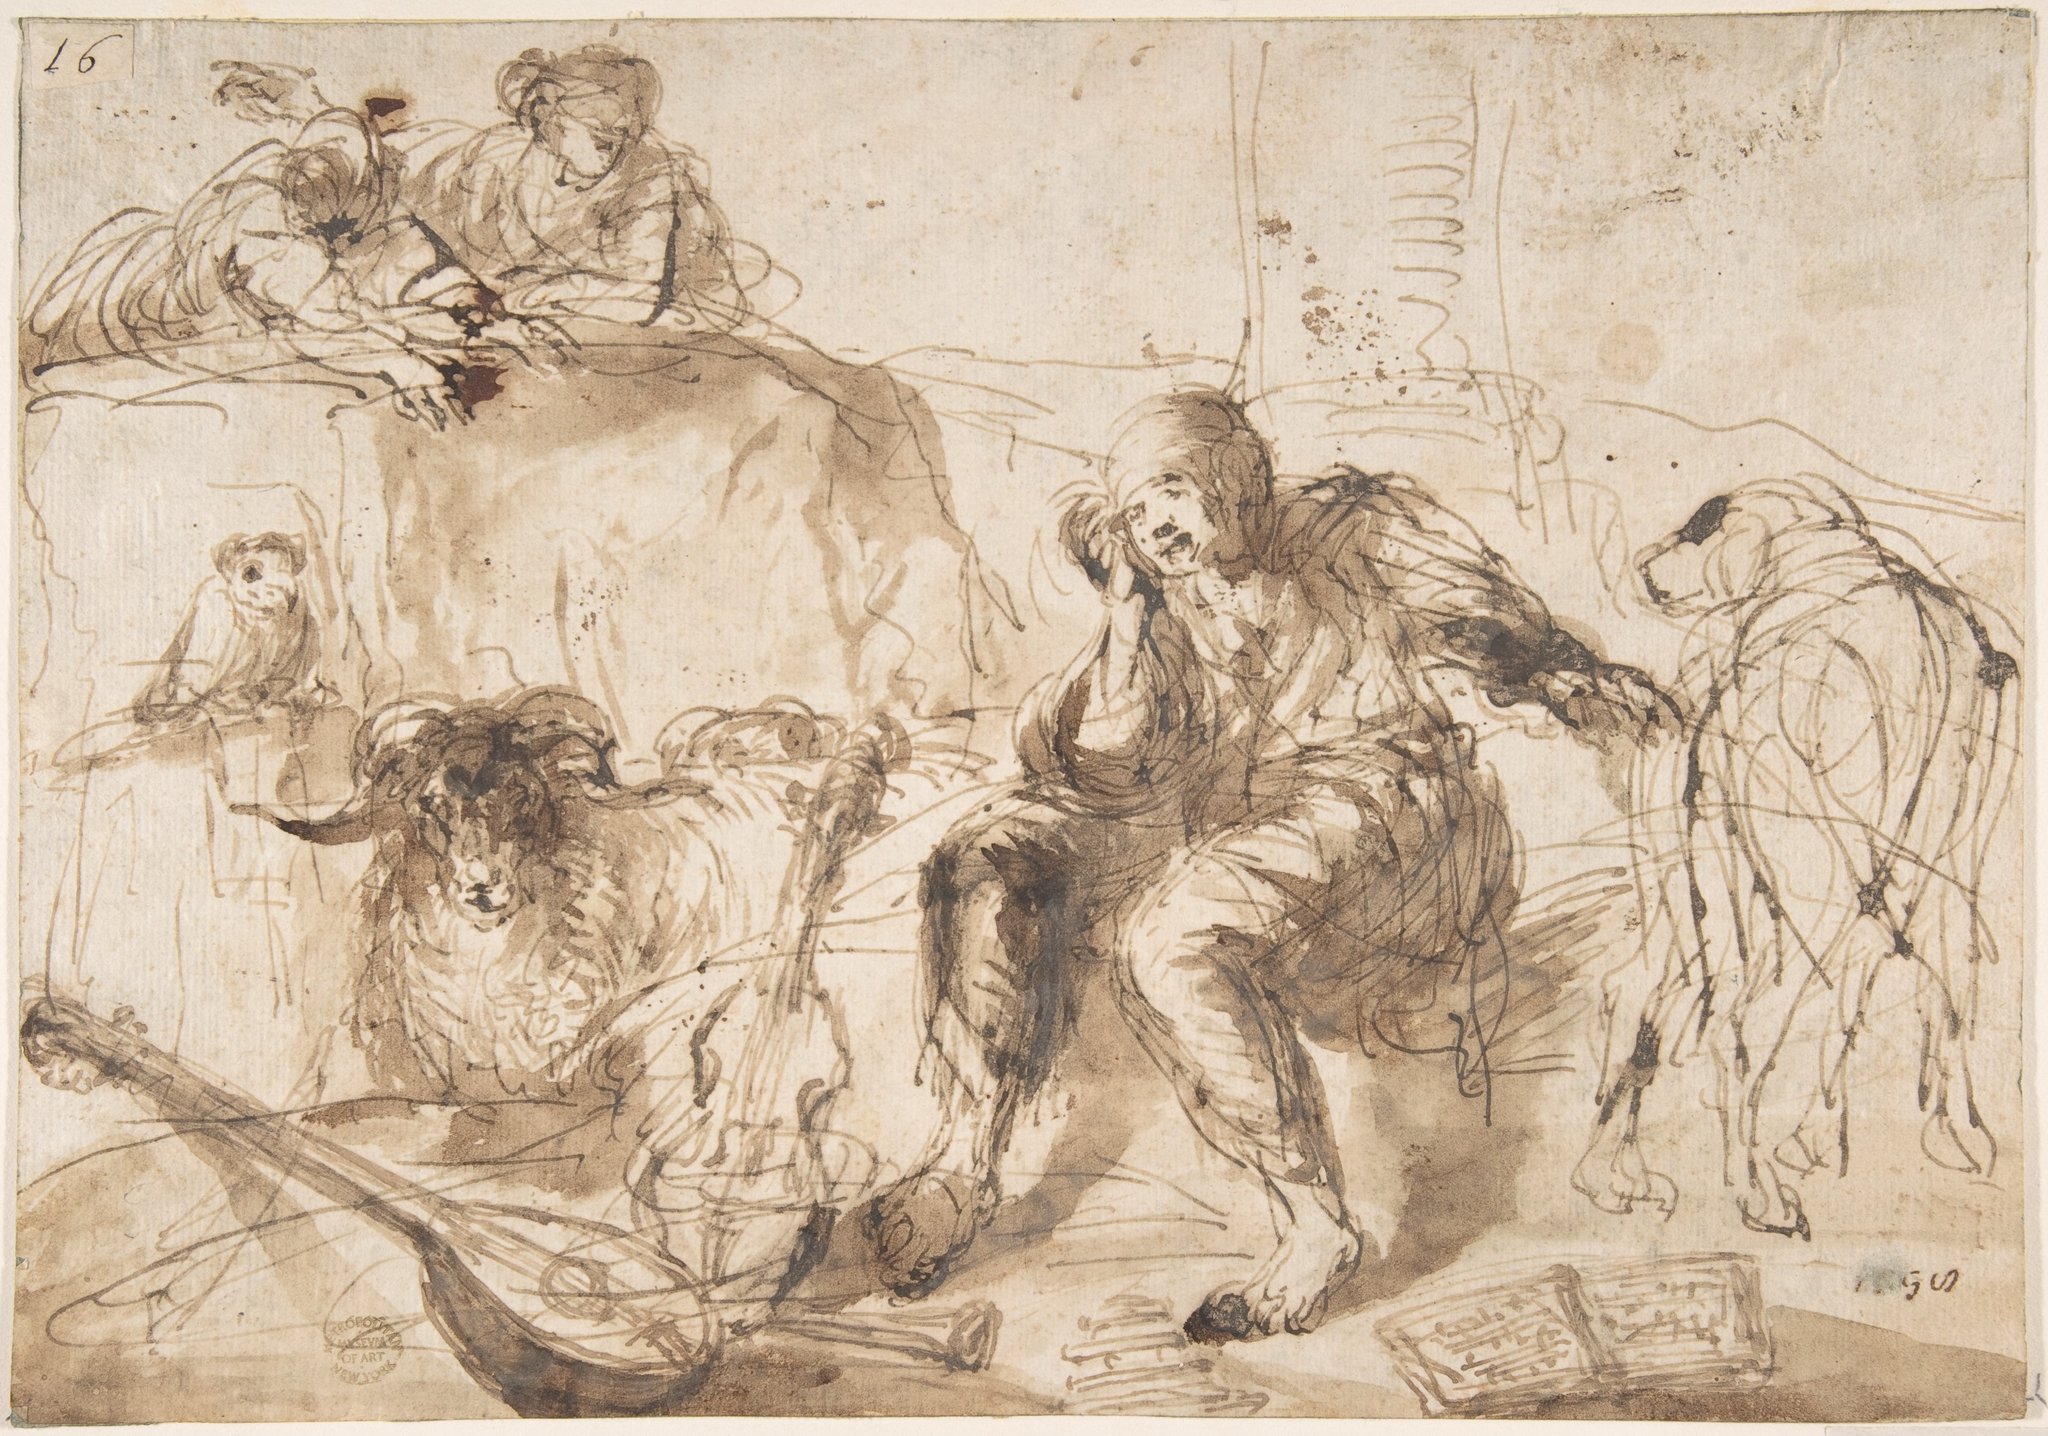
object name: drawing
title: Study of Animals and Figures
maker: giovanni benedetto castiglione (il grechetto)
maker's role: artist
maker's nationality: italian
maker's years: 1609-1664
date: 1609-1664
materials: ink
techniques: brush, pen, wash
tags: human figures,animals